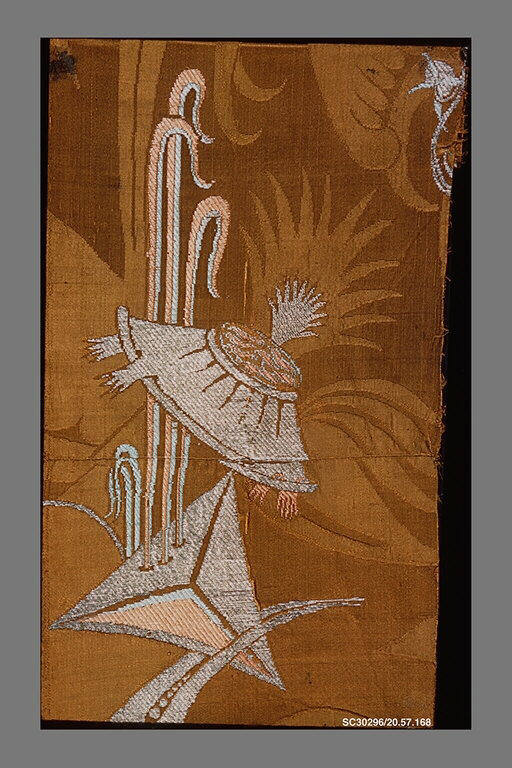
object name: piece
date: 1705-1710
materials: metal thread, silk